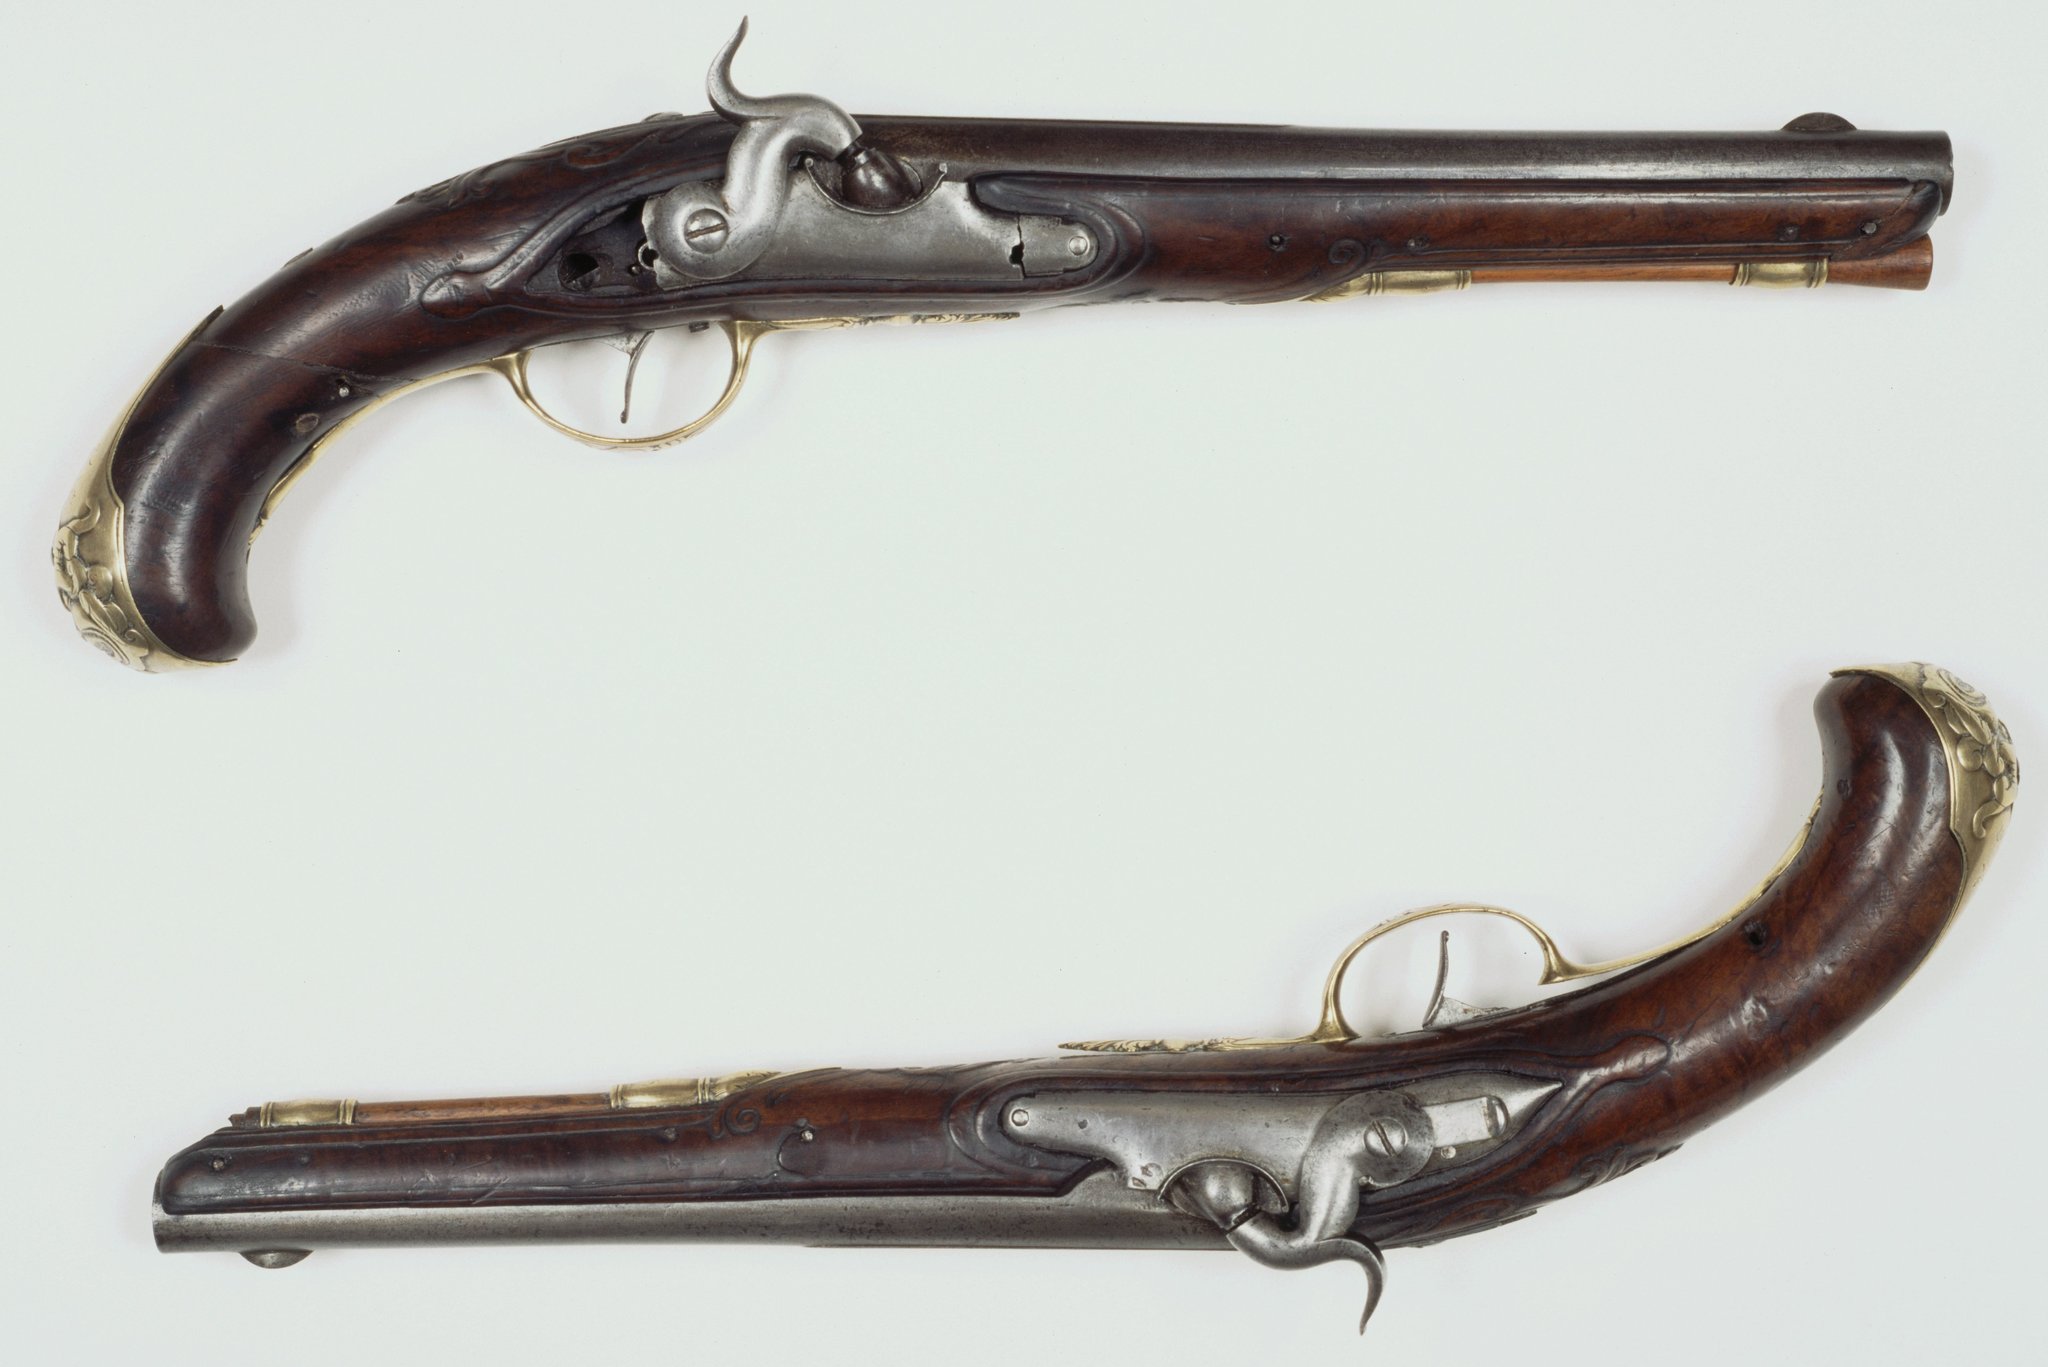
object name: percussion pistol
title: Pistool met later aangebracht percussieslot van C.L. Pelerin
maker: Anonymous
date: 1793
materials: brass, copper, iron, wood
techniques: engraving, gilding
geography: western europe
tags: the hague, william v (prince of orange), netherlands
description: Pistool voor officier, deel van koppel, slot voor 1830 getransformeerd in percussie. Ronde gladde loop met verhoging. IJzeren vizierkorrel en verhoogde vizierkeep. Ronde slotplaat. Koperen gegraveerde zijplaat. Enigszins bewerkte lade. Koperen beslag (verguld messing). Houten laadstok. Pistool in 1793 geschonken door stadhouder Willem V aan luitenant-kolonel C.L. Pelerin, destijds wachtmeester.